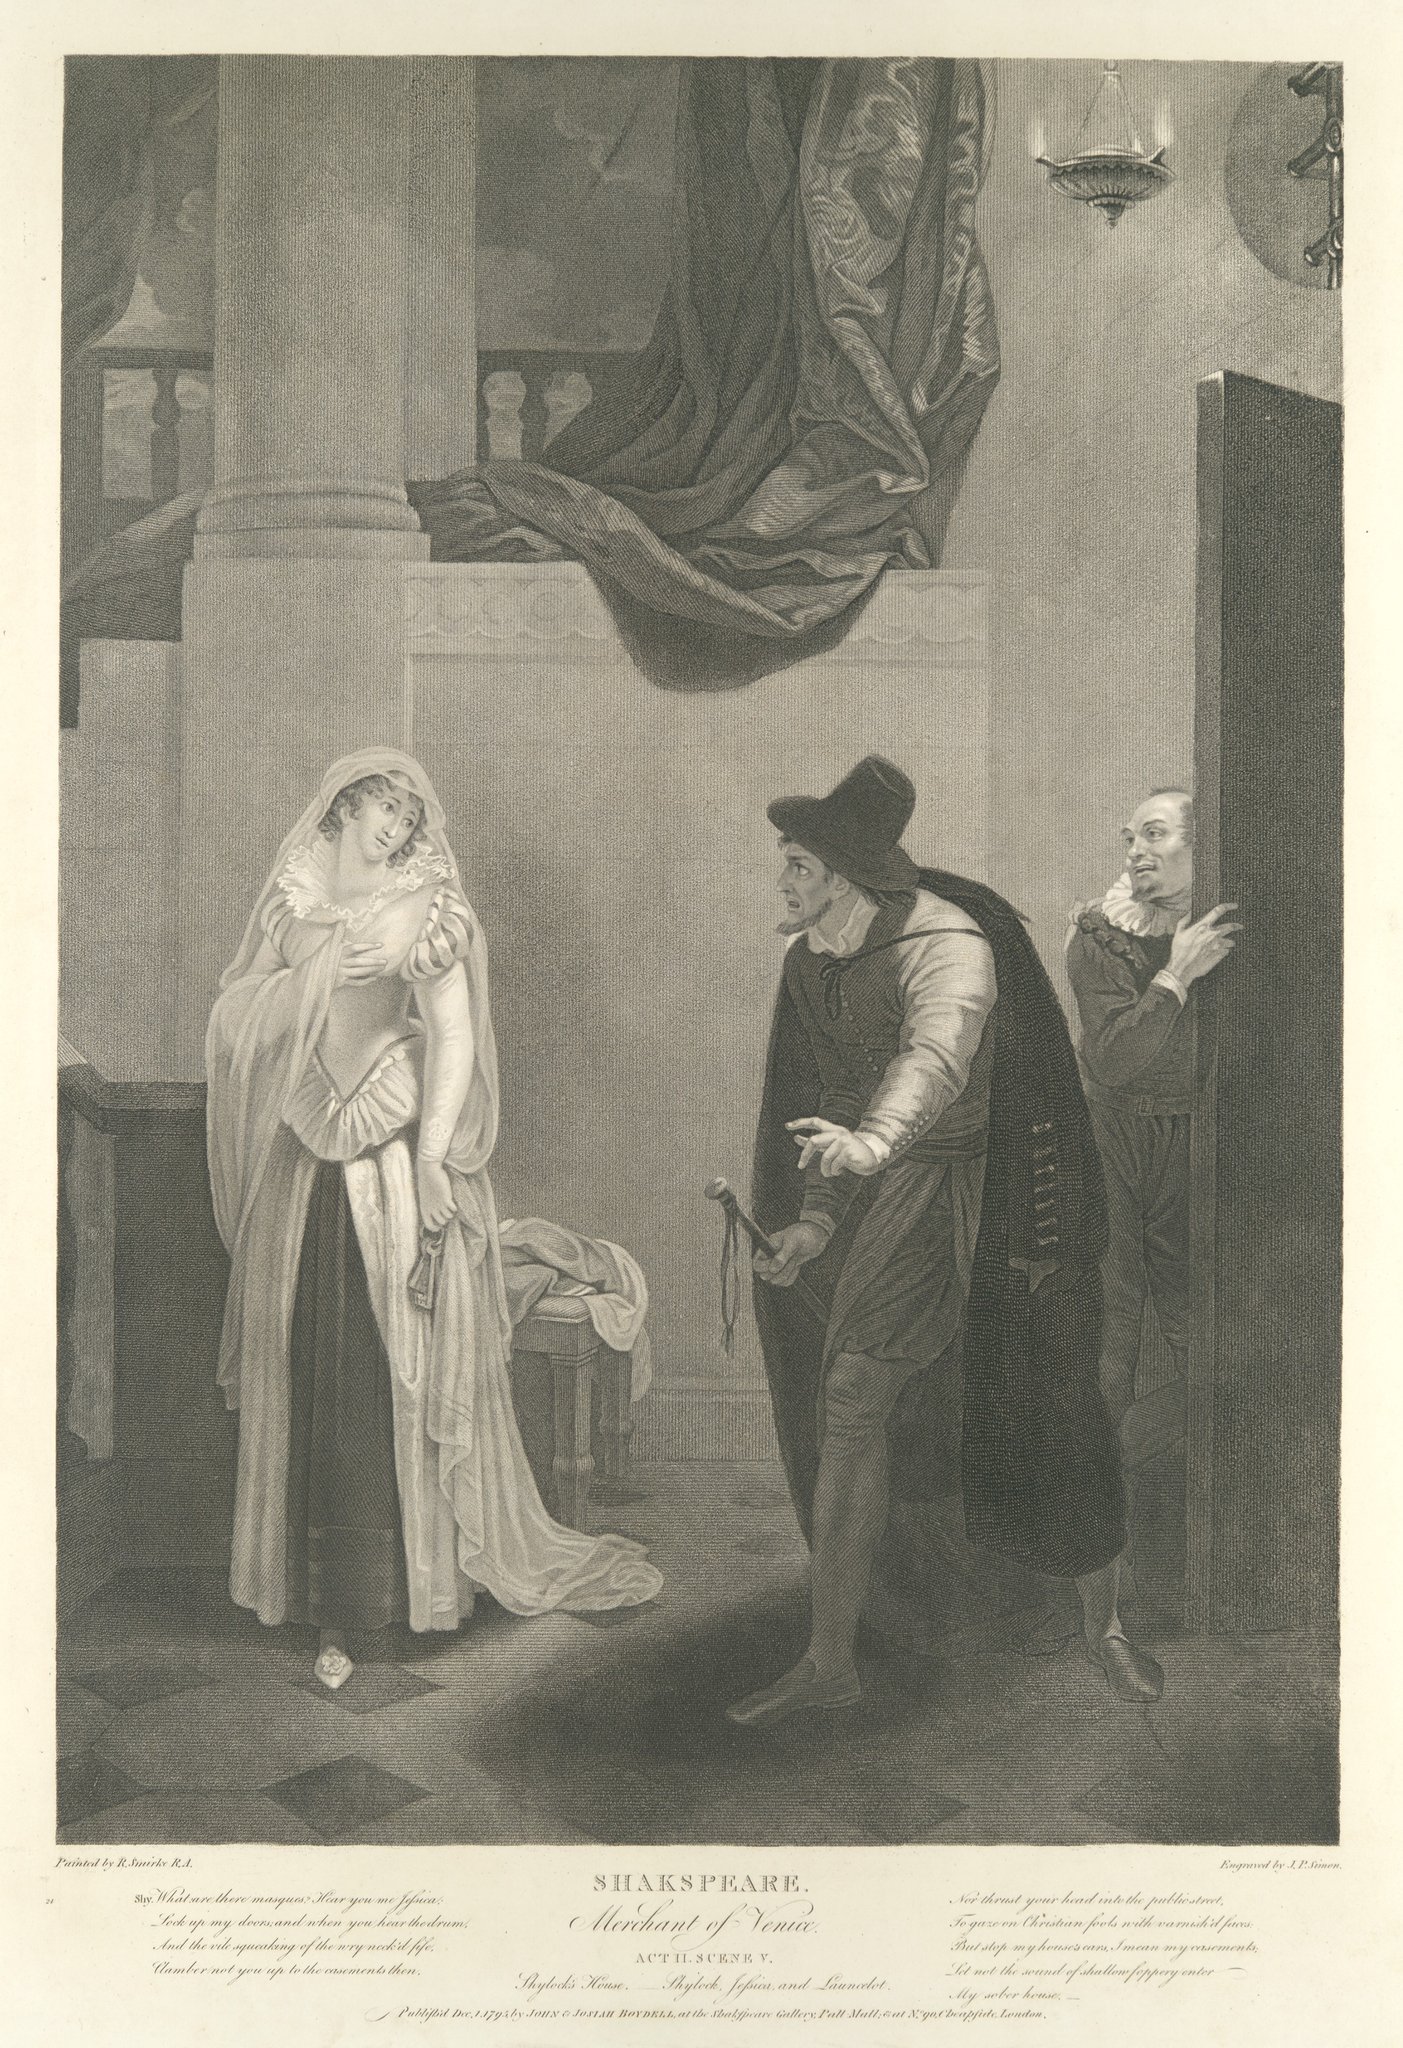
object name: print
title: Shylock's House–Shylock, Jessica and Launcelot (Shakespeare, Merchant of Venice, Act 2, Scene 5)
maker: peter simon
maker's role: engraver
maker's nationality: british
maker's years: 1764-1813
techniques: engraving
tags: shakespeare,men,women